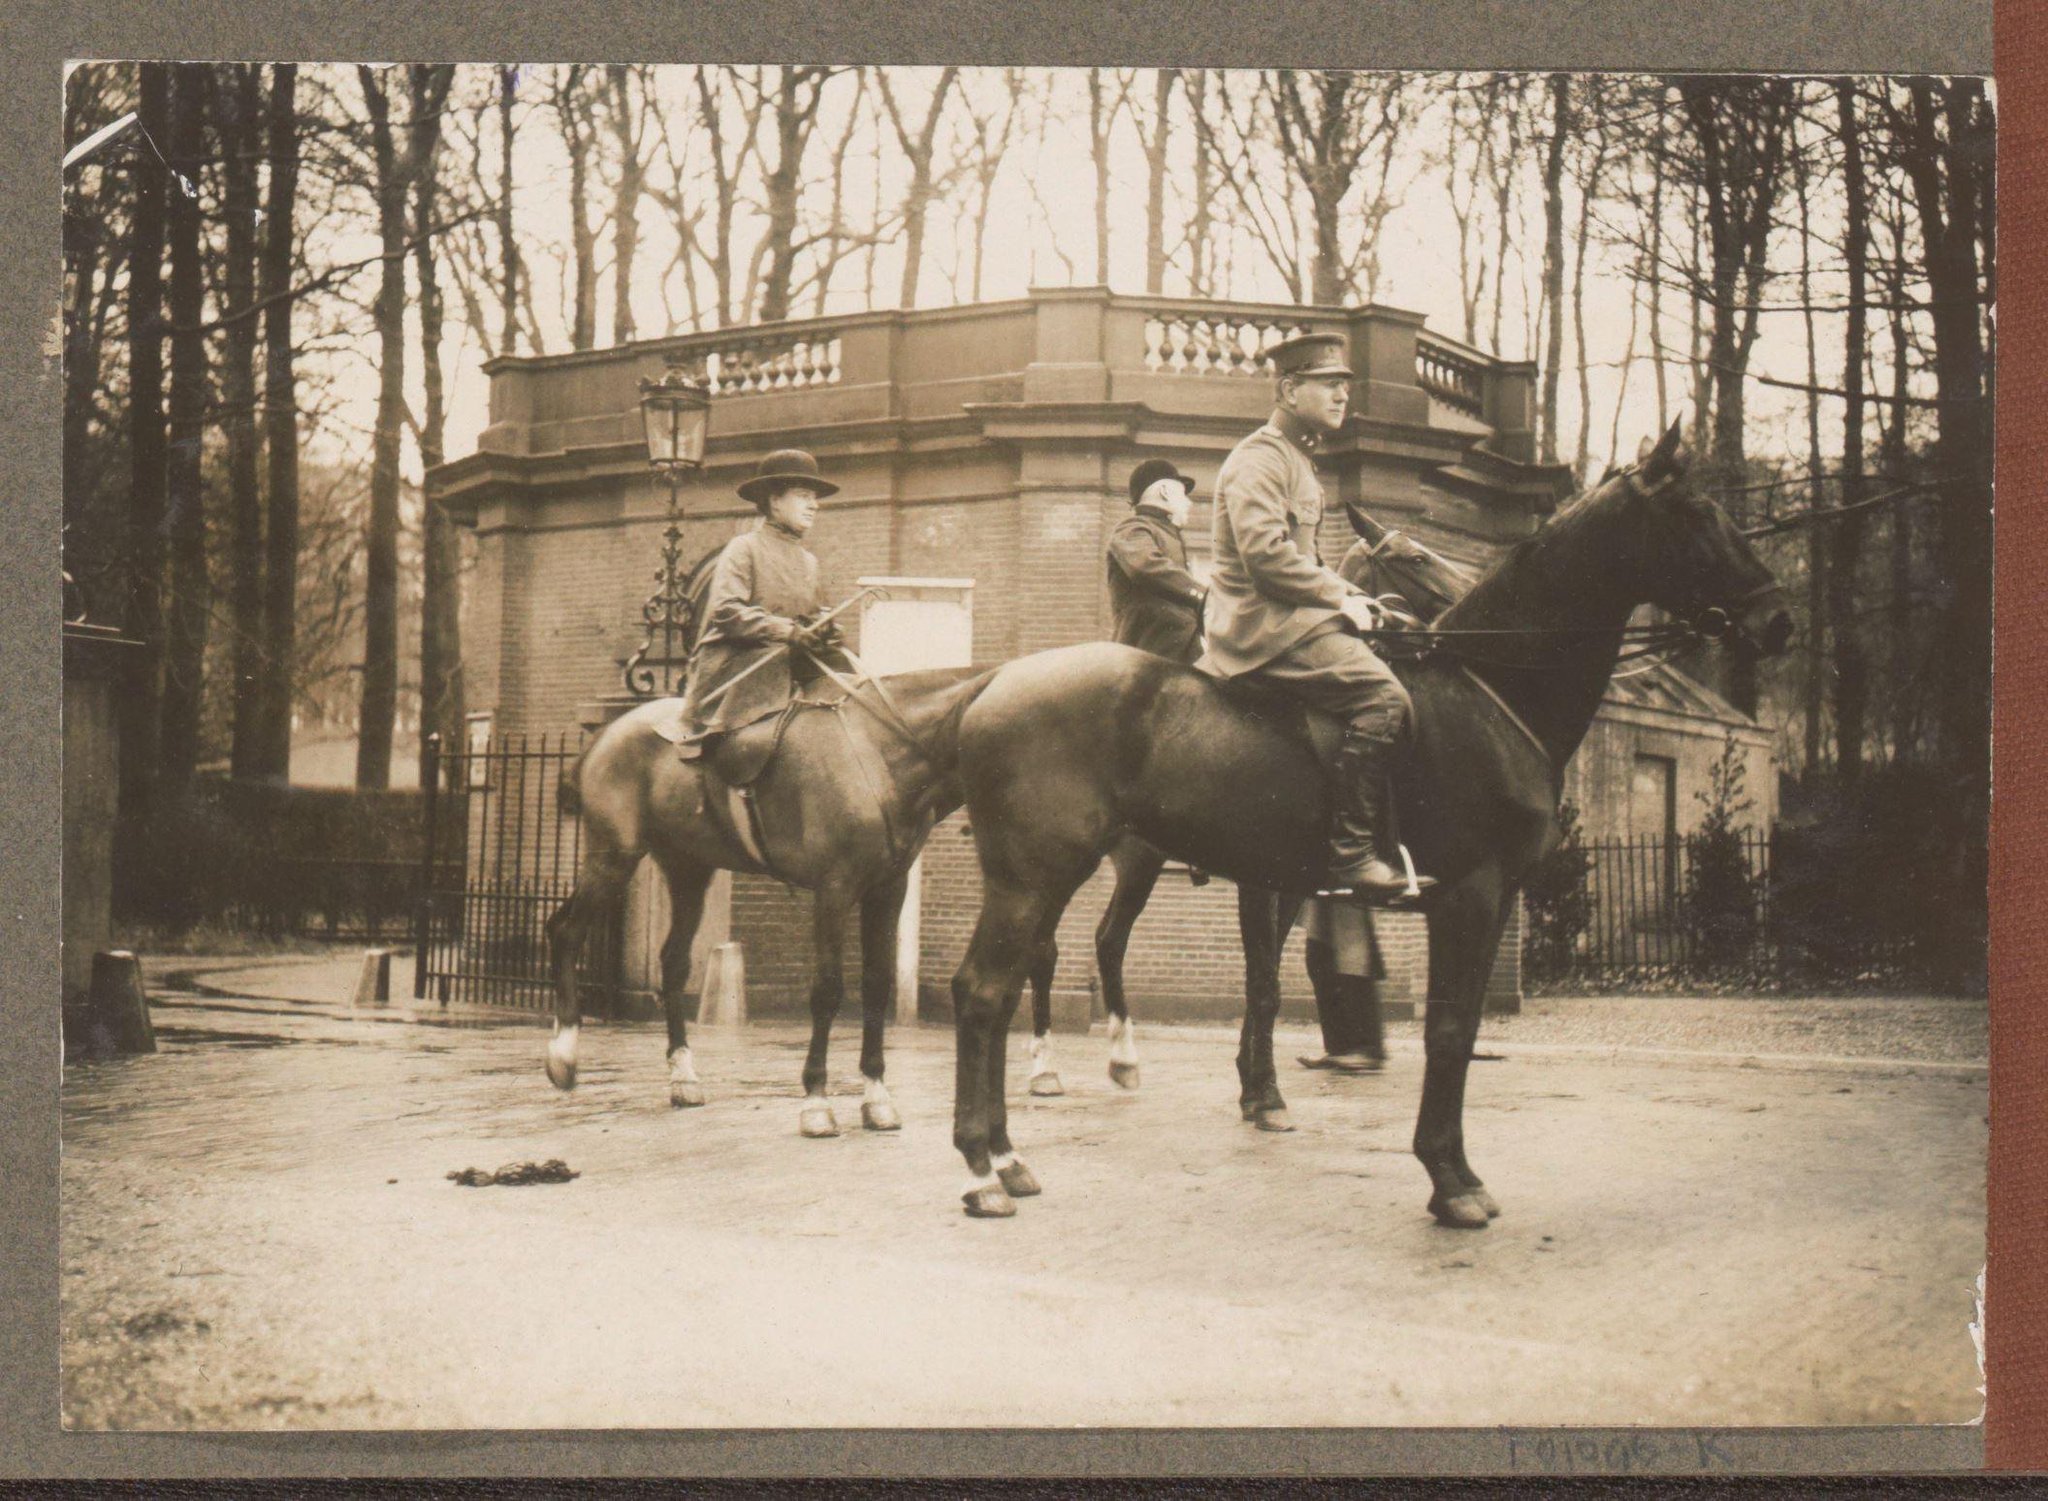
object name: album leaf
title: Ruitertafereel op Koninklijke Houtvesterij Het Loo: ruiters waaronder een vrouw in amazonezit bij ingang van een park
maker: Anonymous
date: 1900-1925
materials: photographic support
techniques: gelatin silver print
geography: het loo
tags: riding a horse, ass, or mule; rider, horseman, hunting, chase, hunting-ground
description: Onderdeel van Fotoalbum van de heer Brams, opperhoutvester van koningin Wilhelmina op Koninklijke Houtvesterij Het Loo.